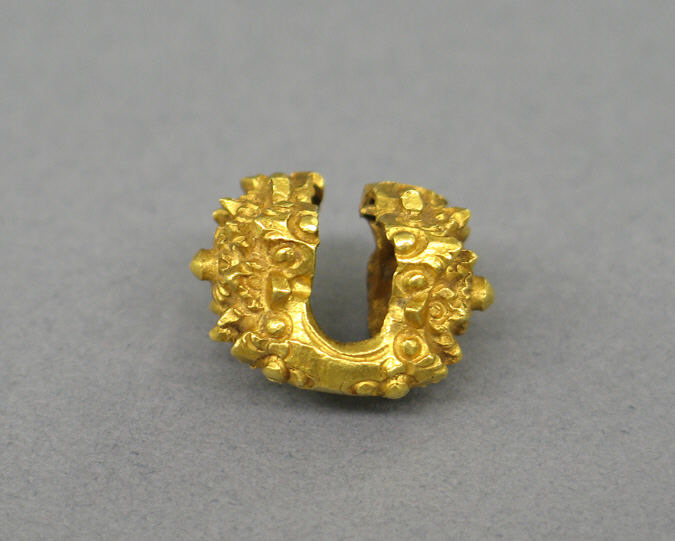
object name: ear clip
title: Pair of Ear Clips with Foliate Design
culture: indonesian, javanese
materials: gold